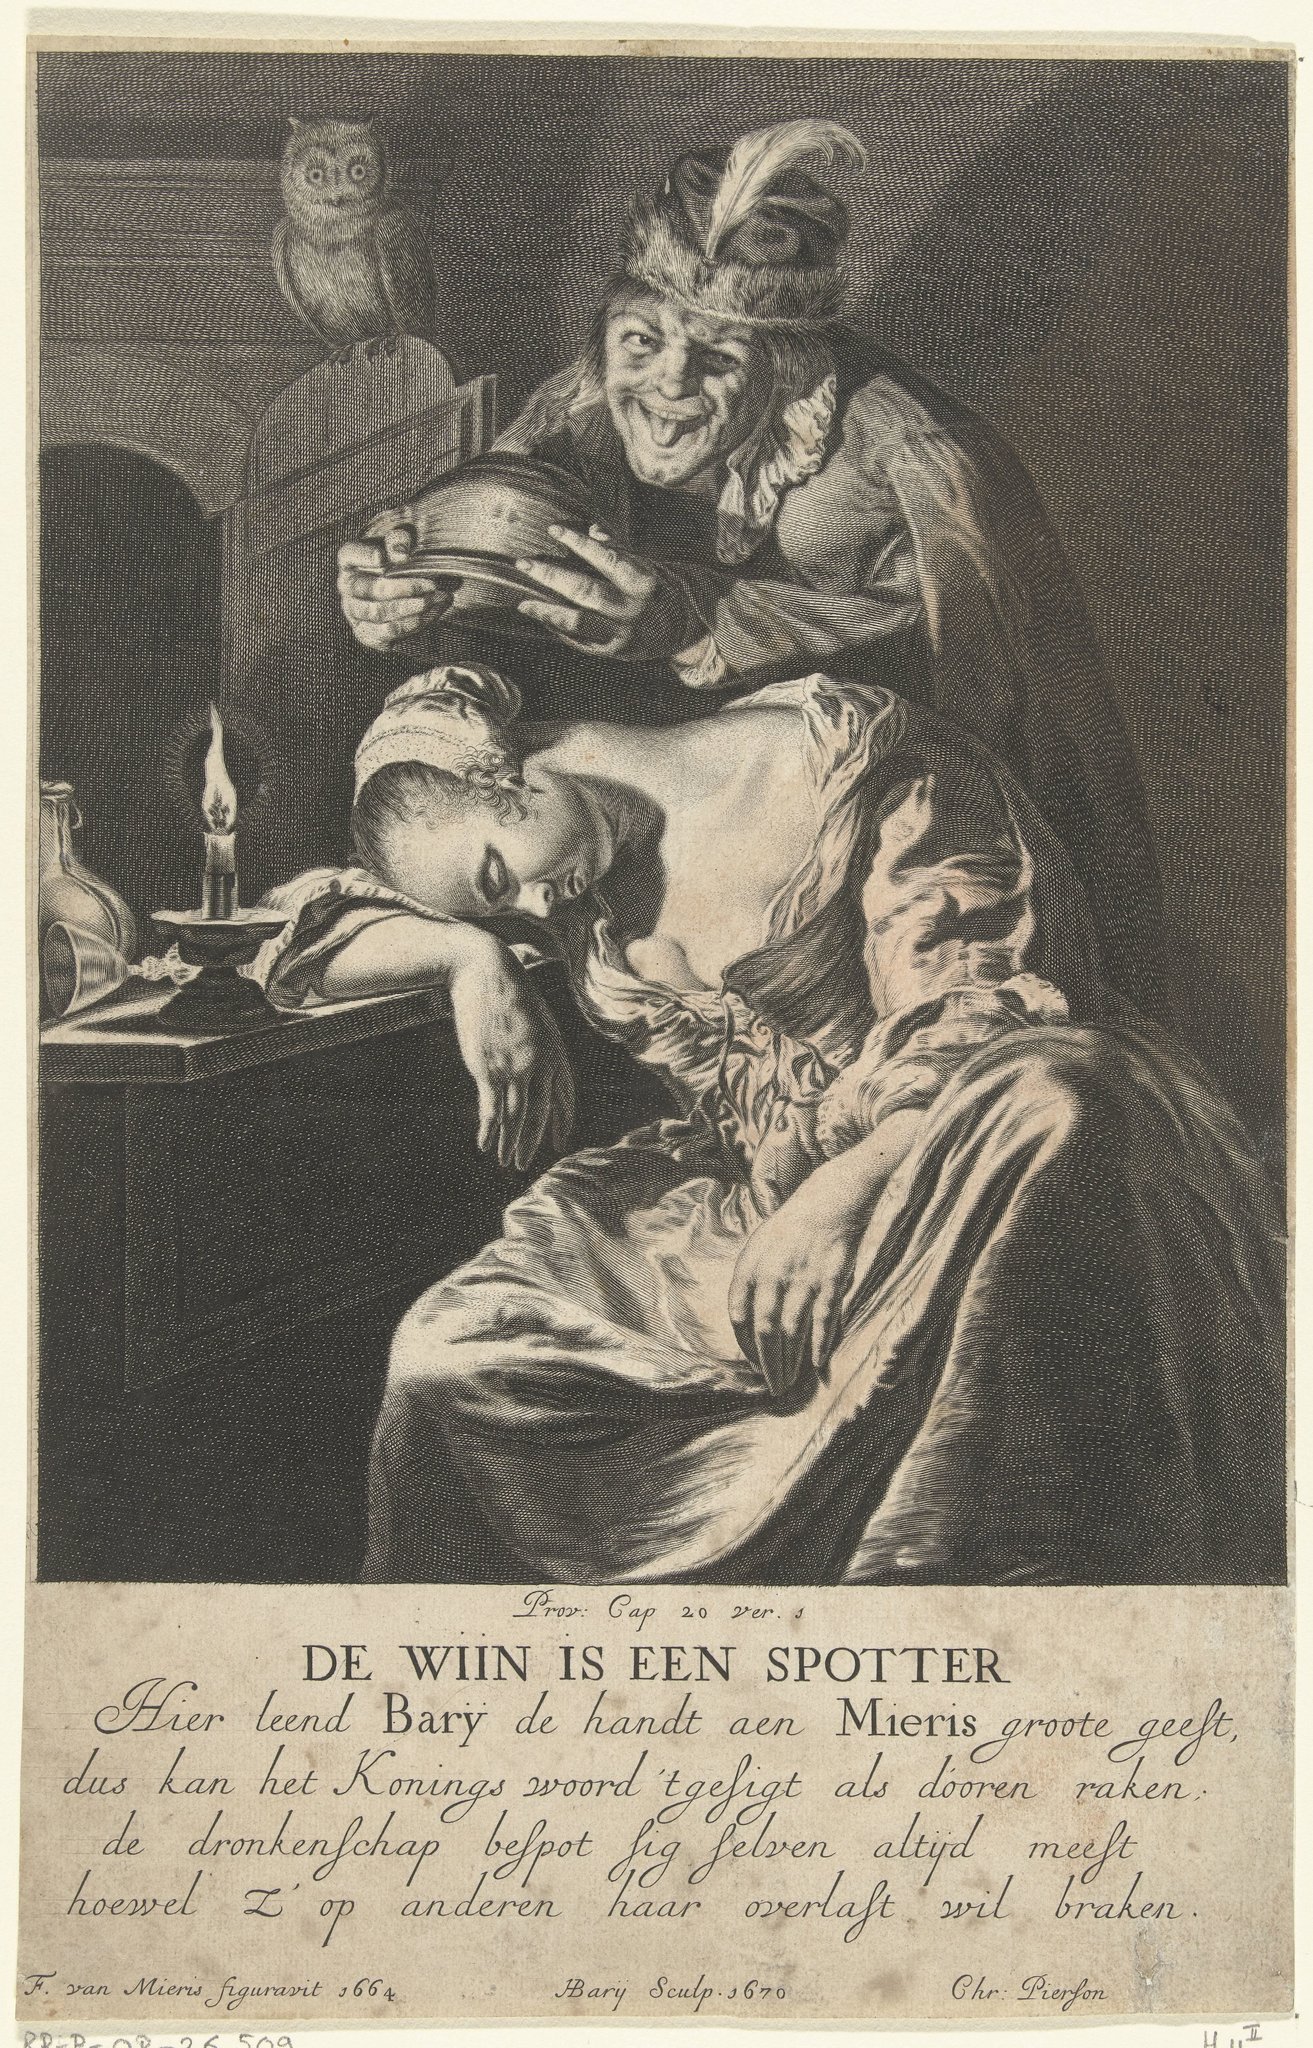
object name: print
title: De wijn is een spotter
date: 1670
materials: paper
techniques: engraving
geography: netherlands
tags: candle, drunkenness, chamber-pot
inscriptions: date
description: Een nar-achtige figuur staat op het punt om een slapende vrouw een pispot op het hoofd te zetten. Onder de voorstelling een vers van vier regels in het Nederlands.